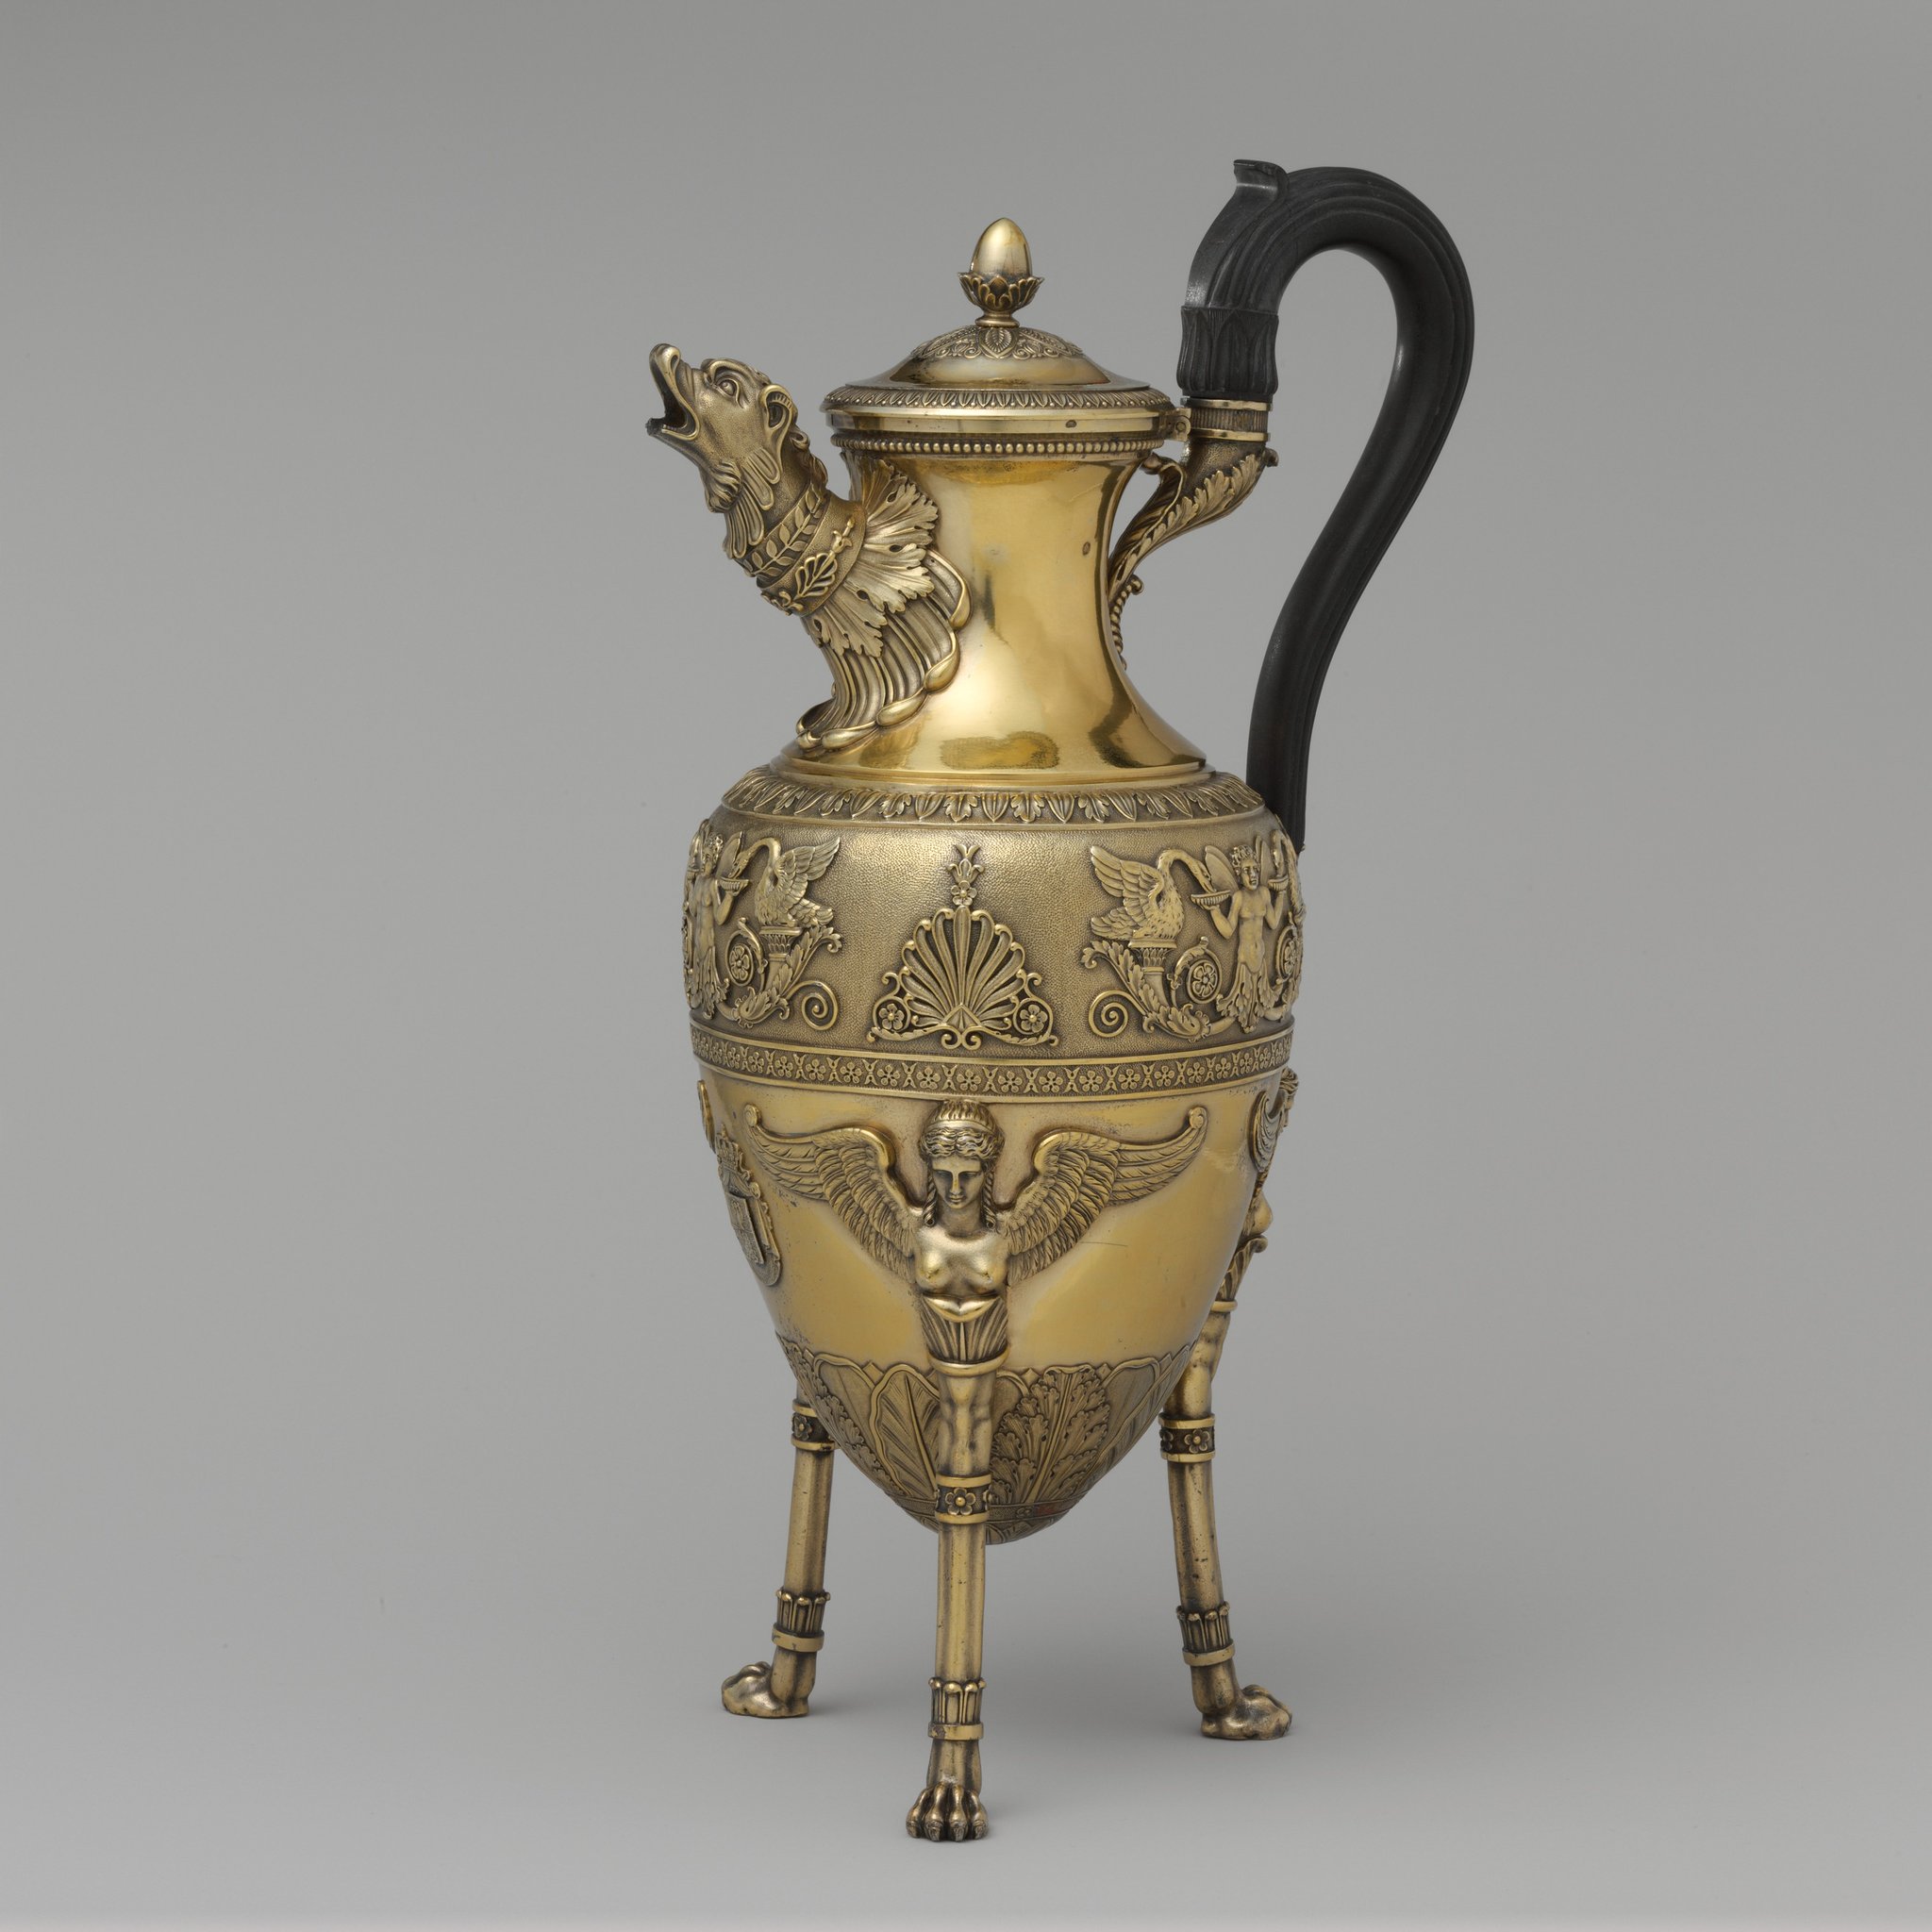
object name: coffeepot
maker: martin-guillaume biennais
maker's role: maker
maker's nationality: french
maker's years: 1764-1843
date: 1797-1809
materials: silver gilt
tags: birds